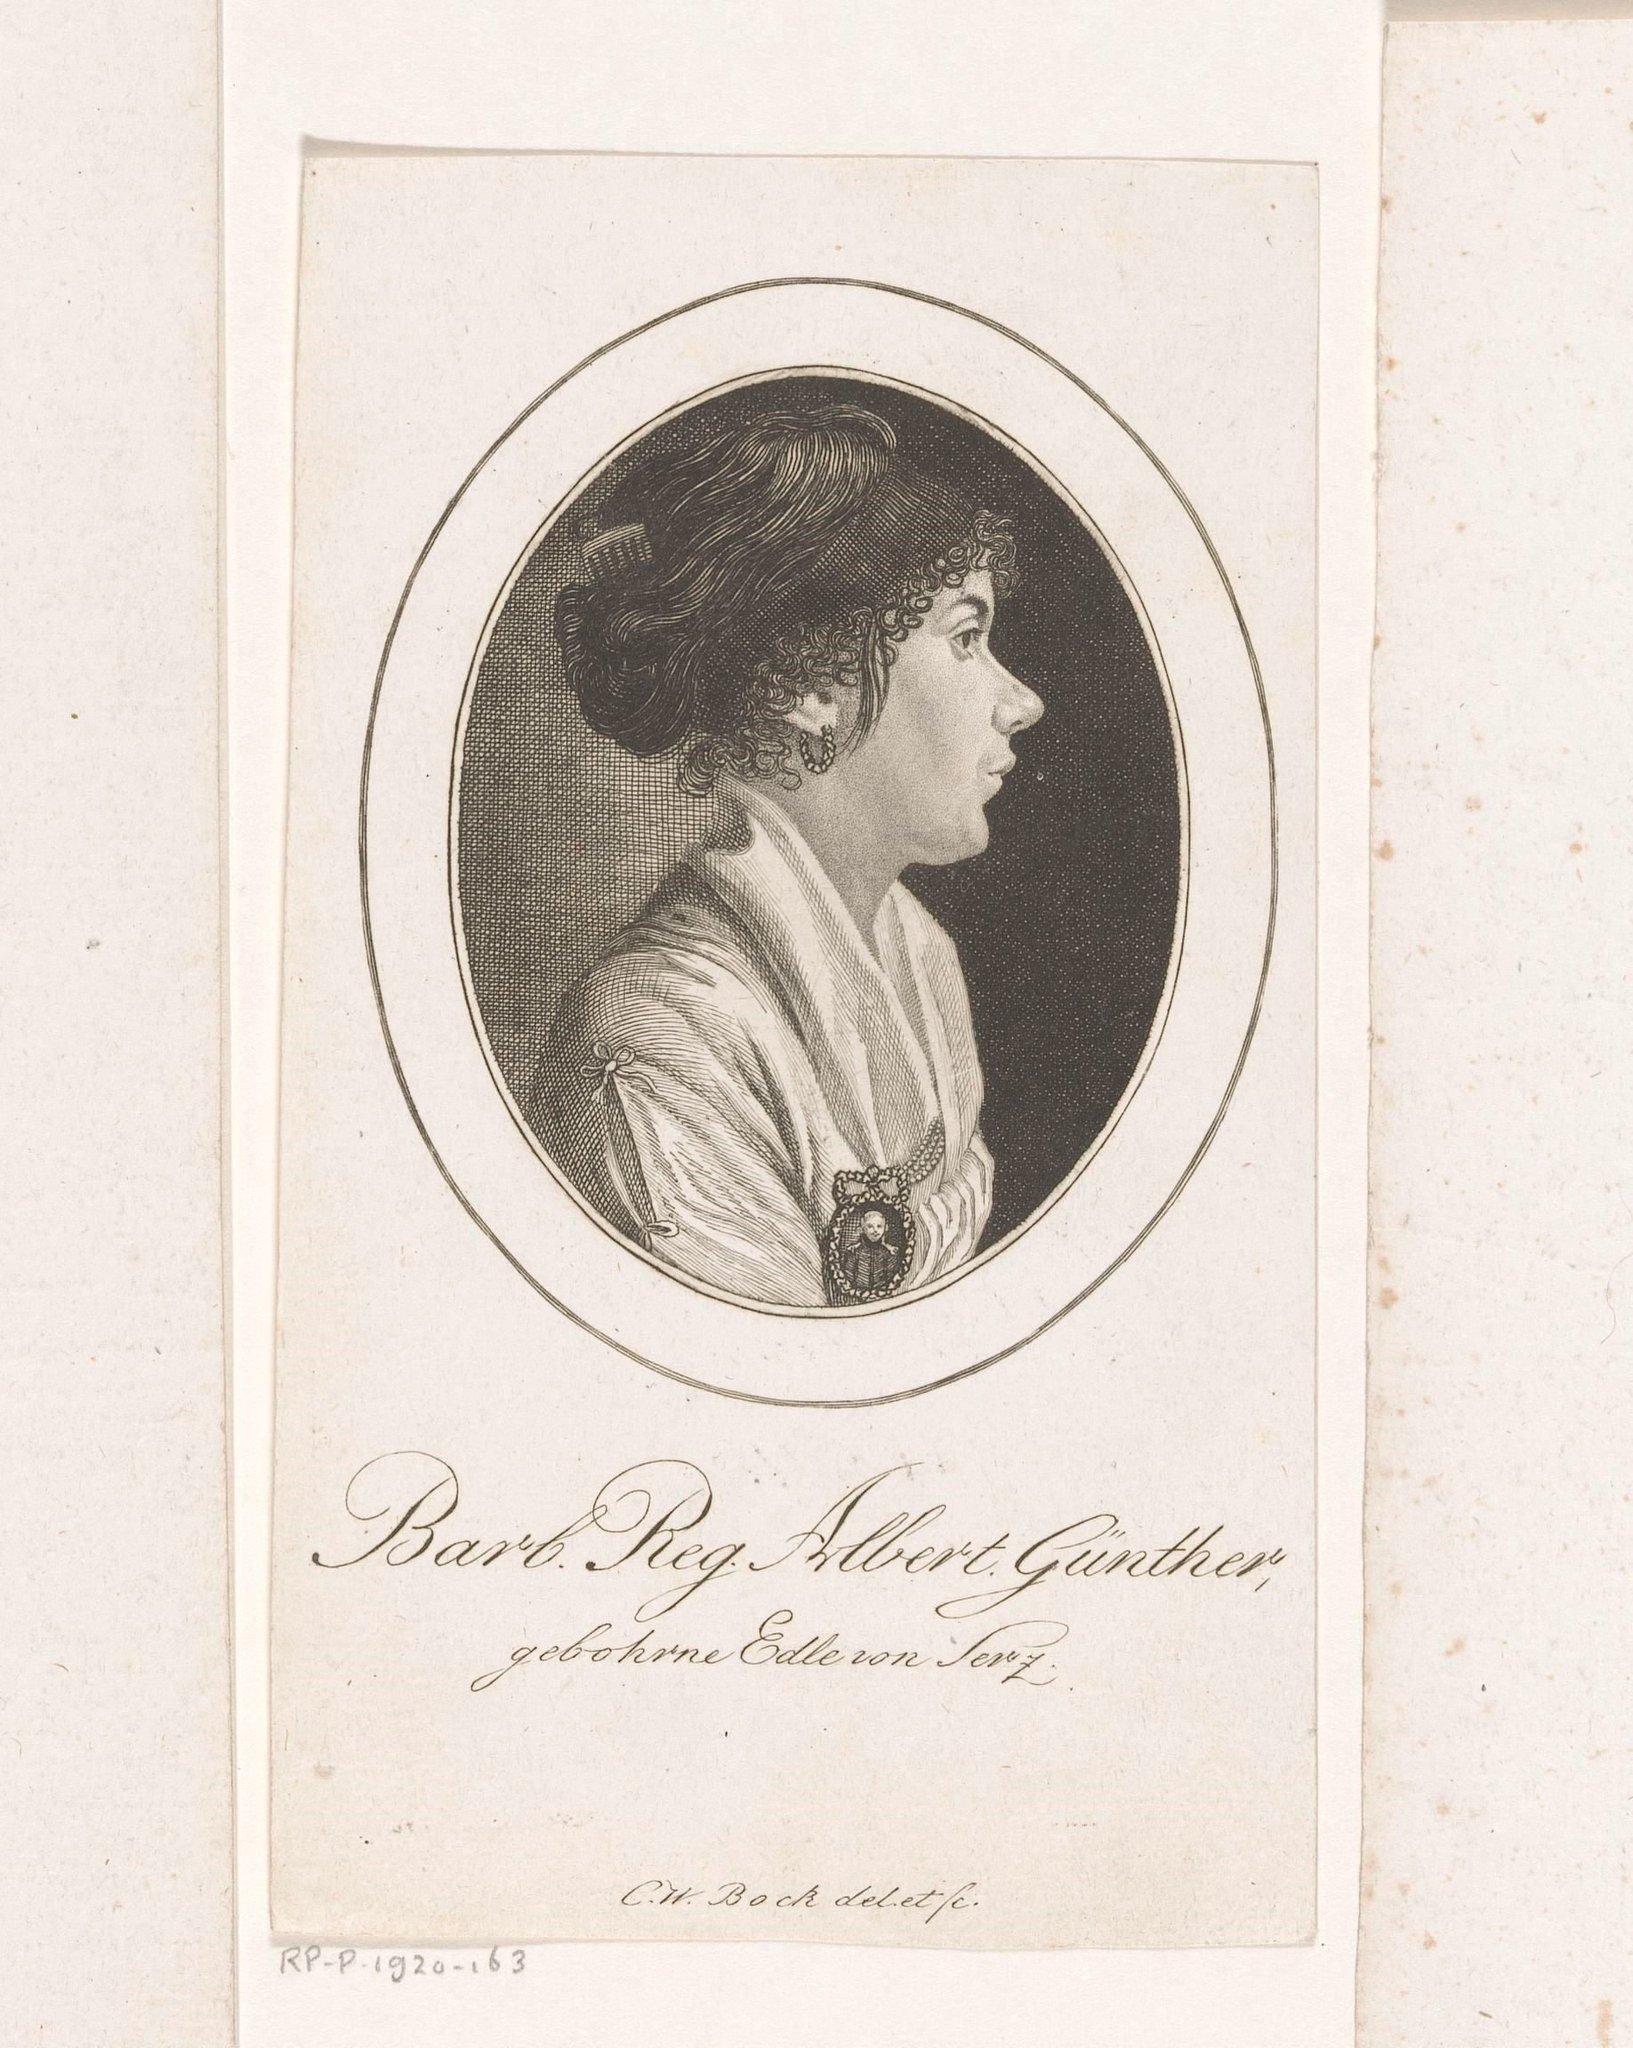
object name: print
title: Portret van Barbara Regina Albertina Günther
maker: christoph wilhelm bock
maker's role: print maker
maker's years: 1755-1836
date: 1780-1836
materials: paper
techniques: engraving, etching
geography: nuremberg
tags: historical persons - bb - woman, brooch, agraffe, clasp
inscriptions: collector's mark: Lugt 2228